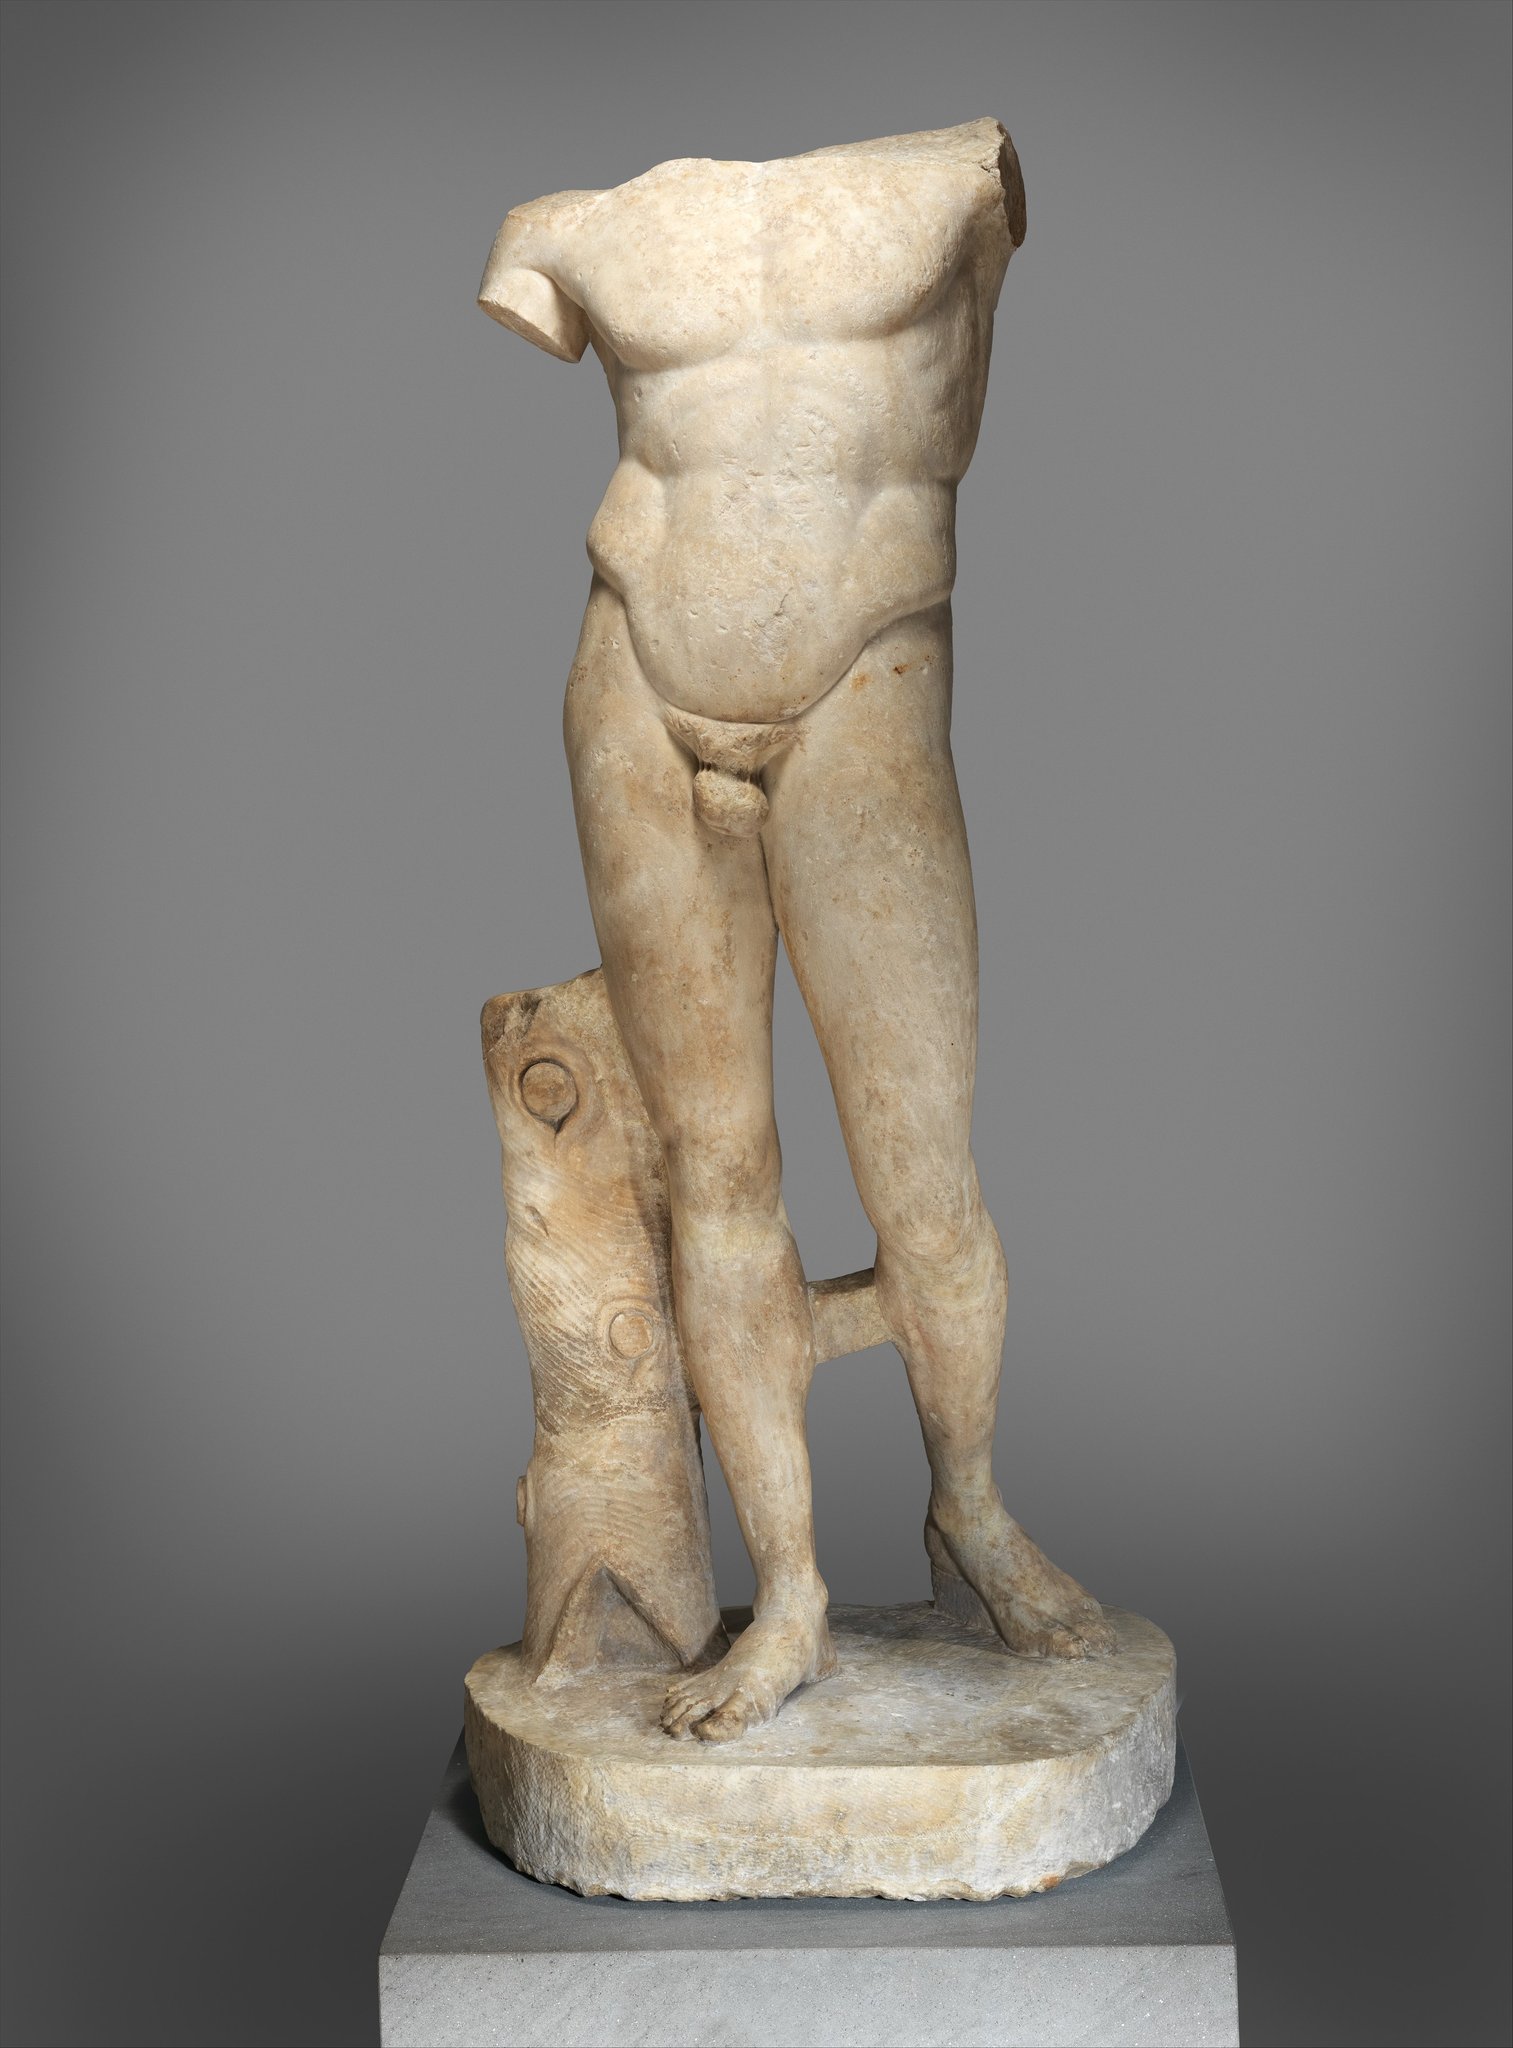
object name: statue of the diadoumenos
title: Marble statue of the Diadoumenos (youth tying a fillet around his head)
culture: roman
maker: polykleitos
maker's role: artist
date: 1-200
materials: marble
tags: male nudes,athletes